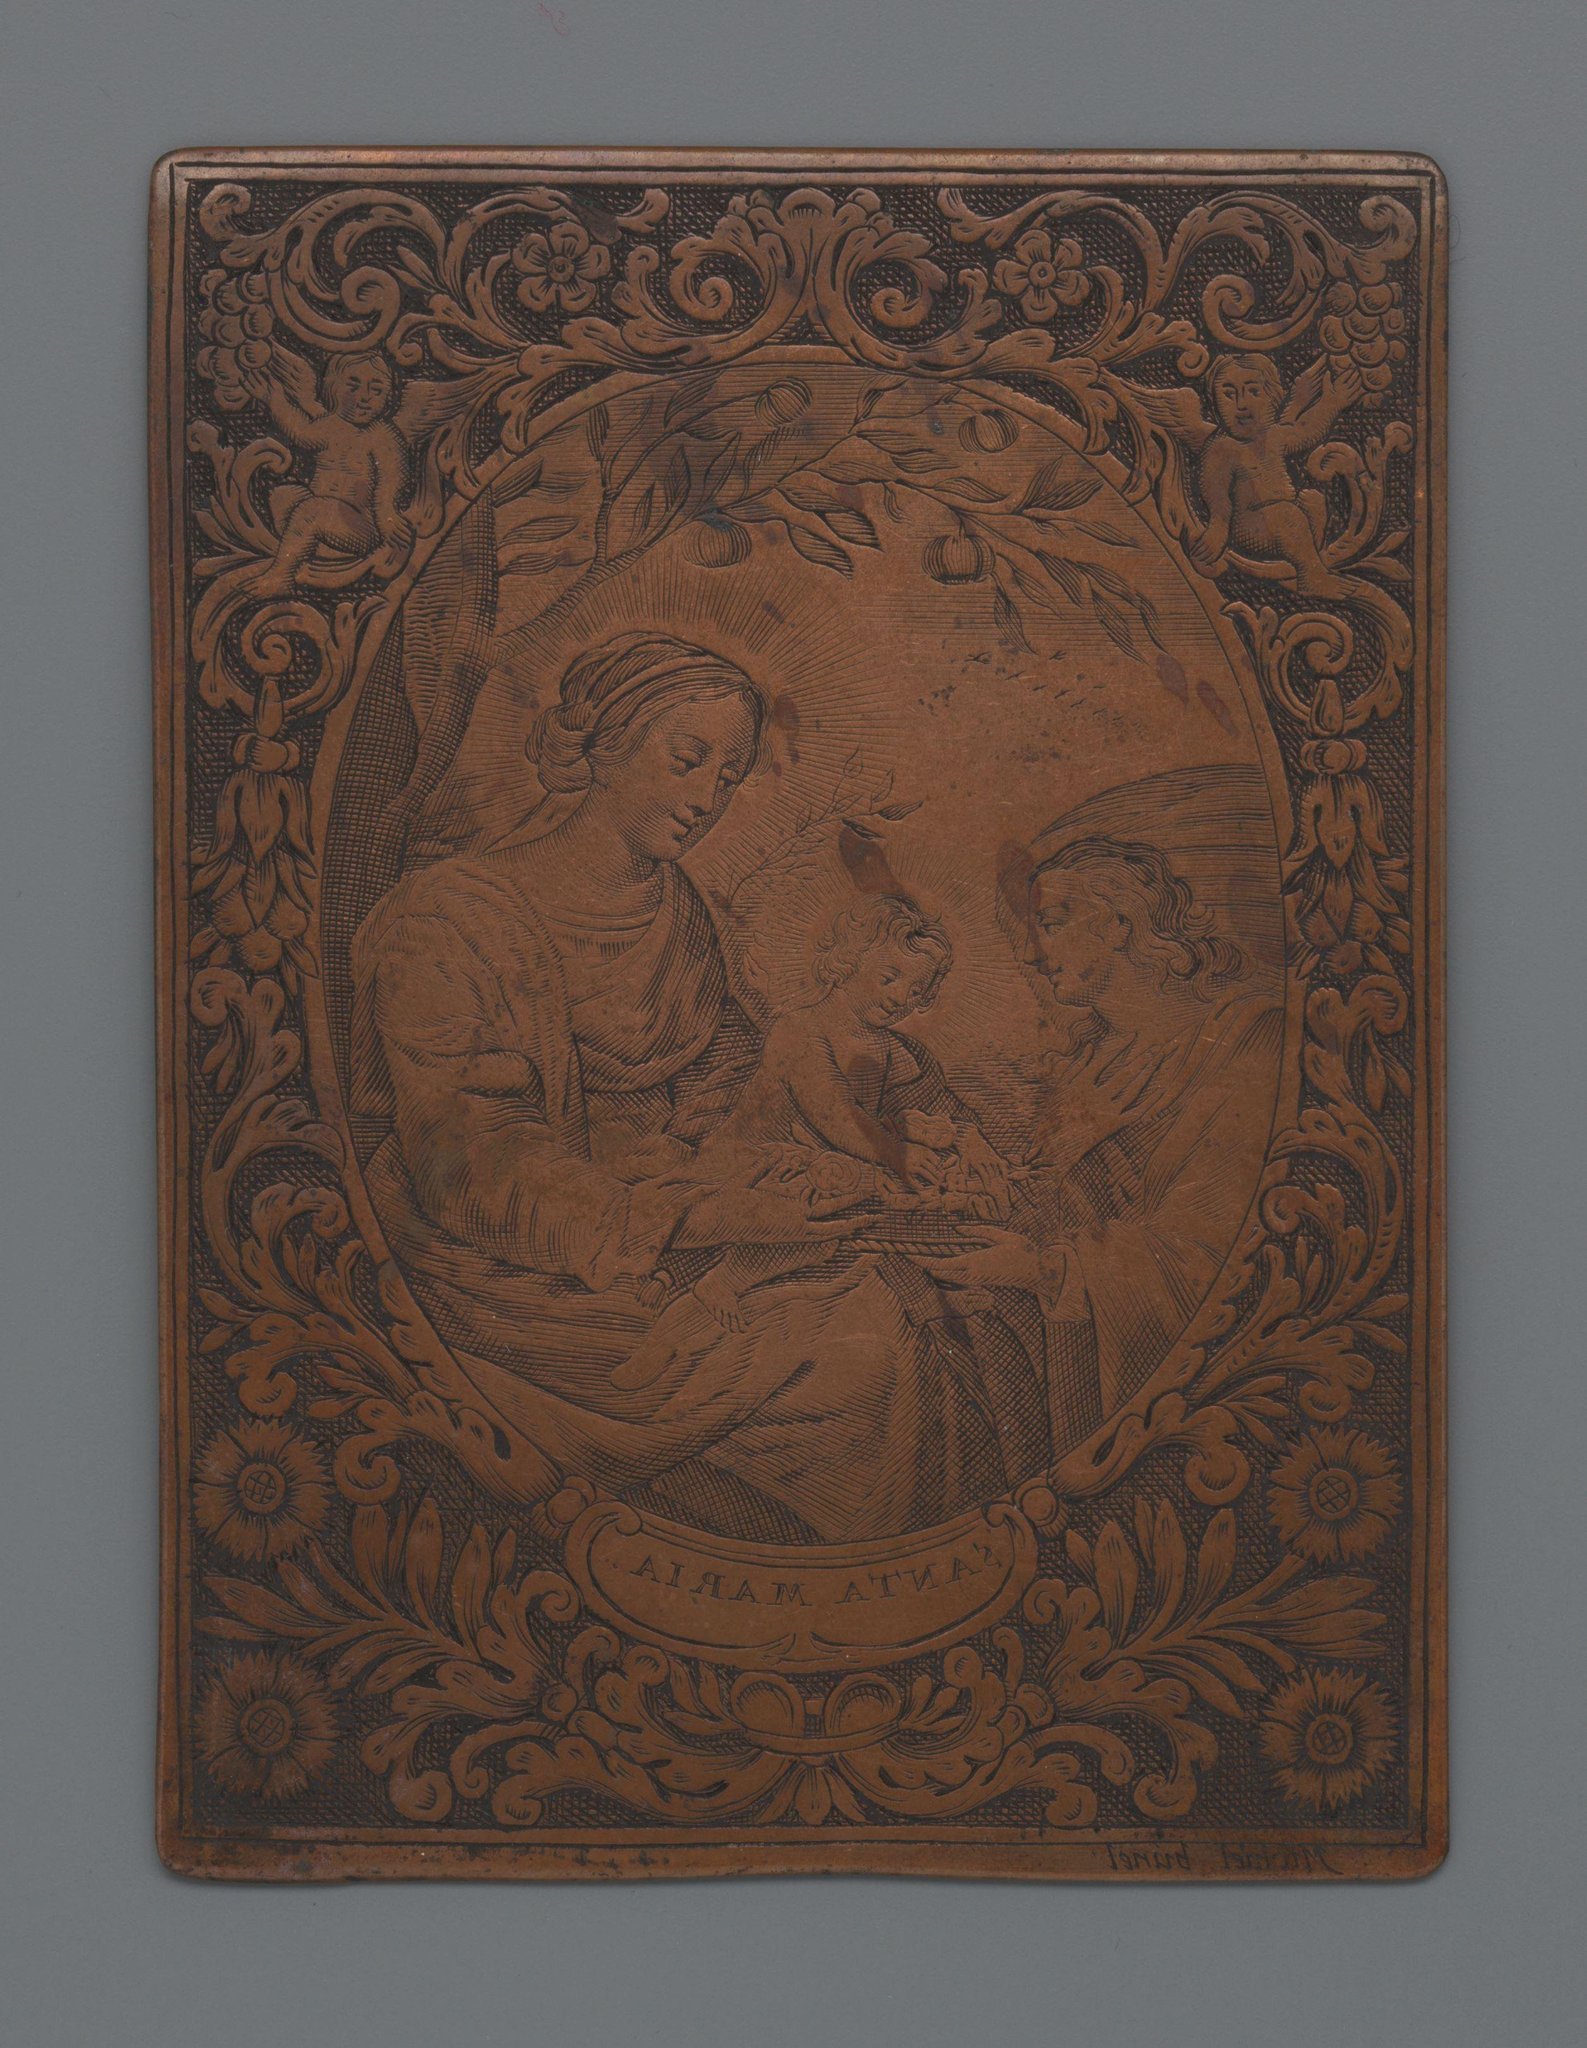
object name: copper plate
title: Koperplaat met Maria met kind en engel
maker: michel bunel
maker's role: print maker, publisher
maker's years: 1670-1739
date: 1680-1739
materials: copper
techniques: engraving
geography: antwerp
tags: mary sitting or enthroned, the christ-child on her knee (christ-child to mary's left)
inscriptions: signature: ‘Michiel Bunel’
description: De platen (RP-D-2014-9-1 t/m 35) zijn vrijwel allemaal vervaardigd door anonieme graveurs werkend voor de Antwerpse uitgevers Cornelis Galle, Frans Huberti (Huybrechts), Theodor van Merlen II en Michel Bunel. Vermoedelijk zijn ze uiteindelijk beland in één fonds, wellicht dat van Michel Bunel (1670-1739) en warden sindsdien bij elkaar bewaard. Afwijkend is de grote prent van Henry Verbruggen met een weergave van de Preekstoel uit de St. Gudule-kerk te Brussel. Twee prenten zijn verpakt in een oude afdruk van de prent, zoals te doen gebruikelijk in uitgeverijen (vergl. oude platen in Museum Plantijn Moretus, Antwerpen). Van 8 platen heeft de vorige eigenaar afdrukken laten maken op modern papier.